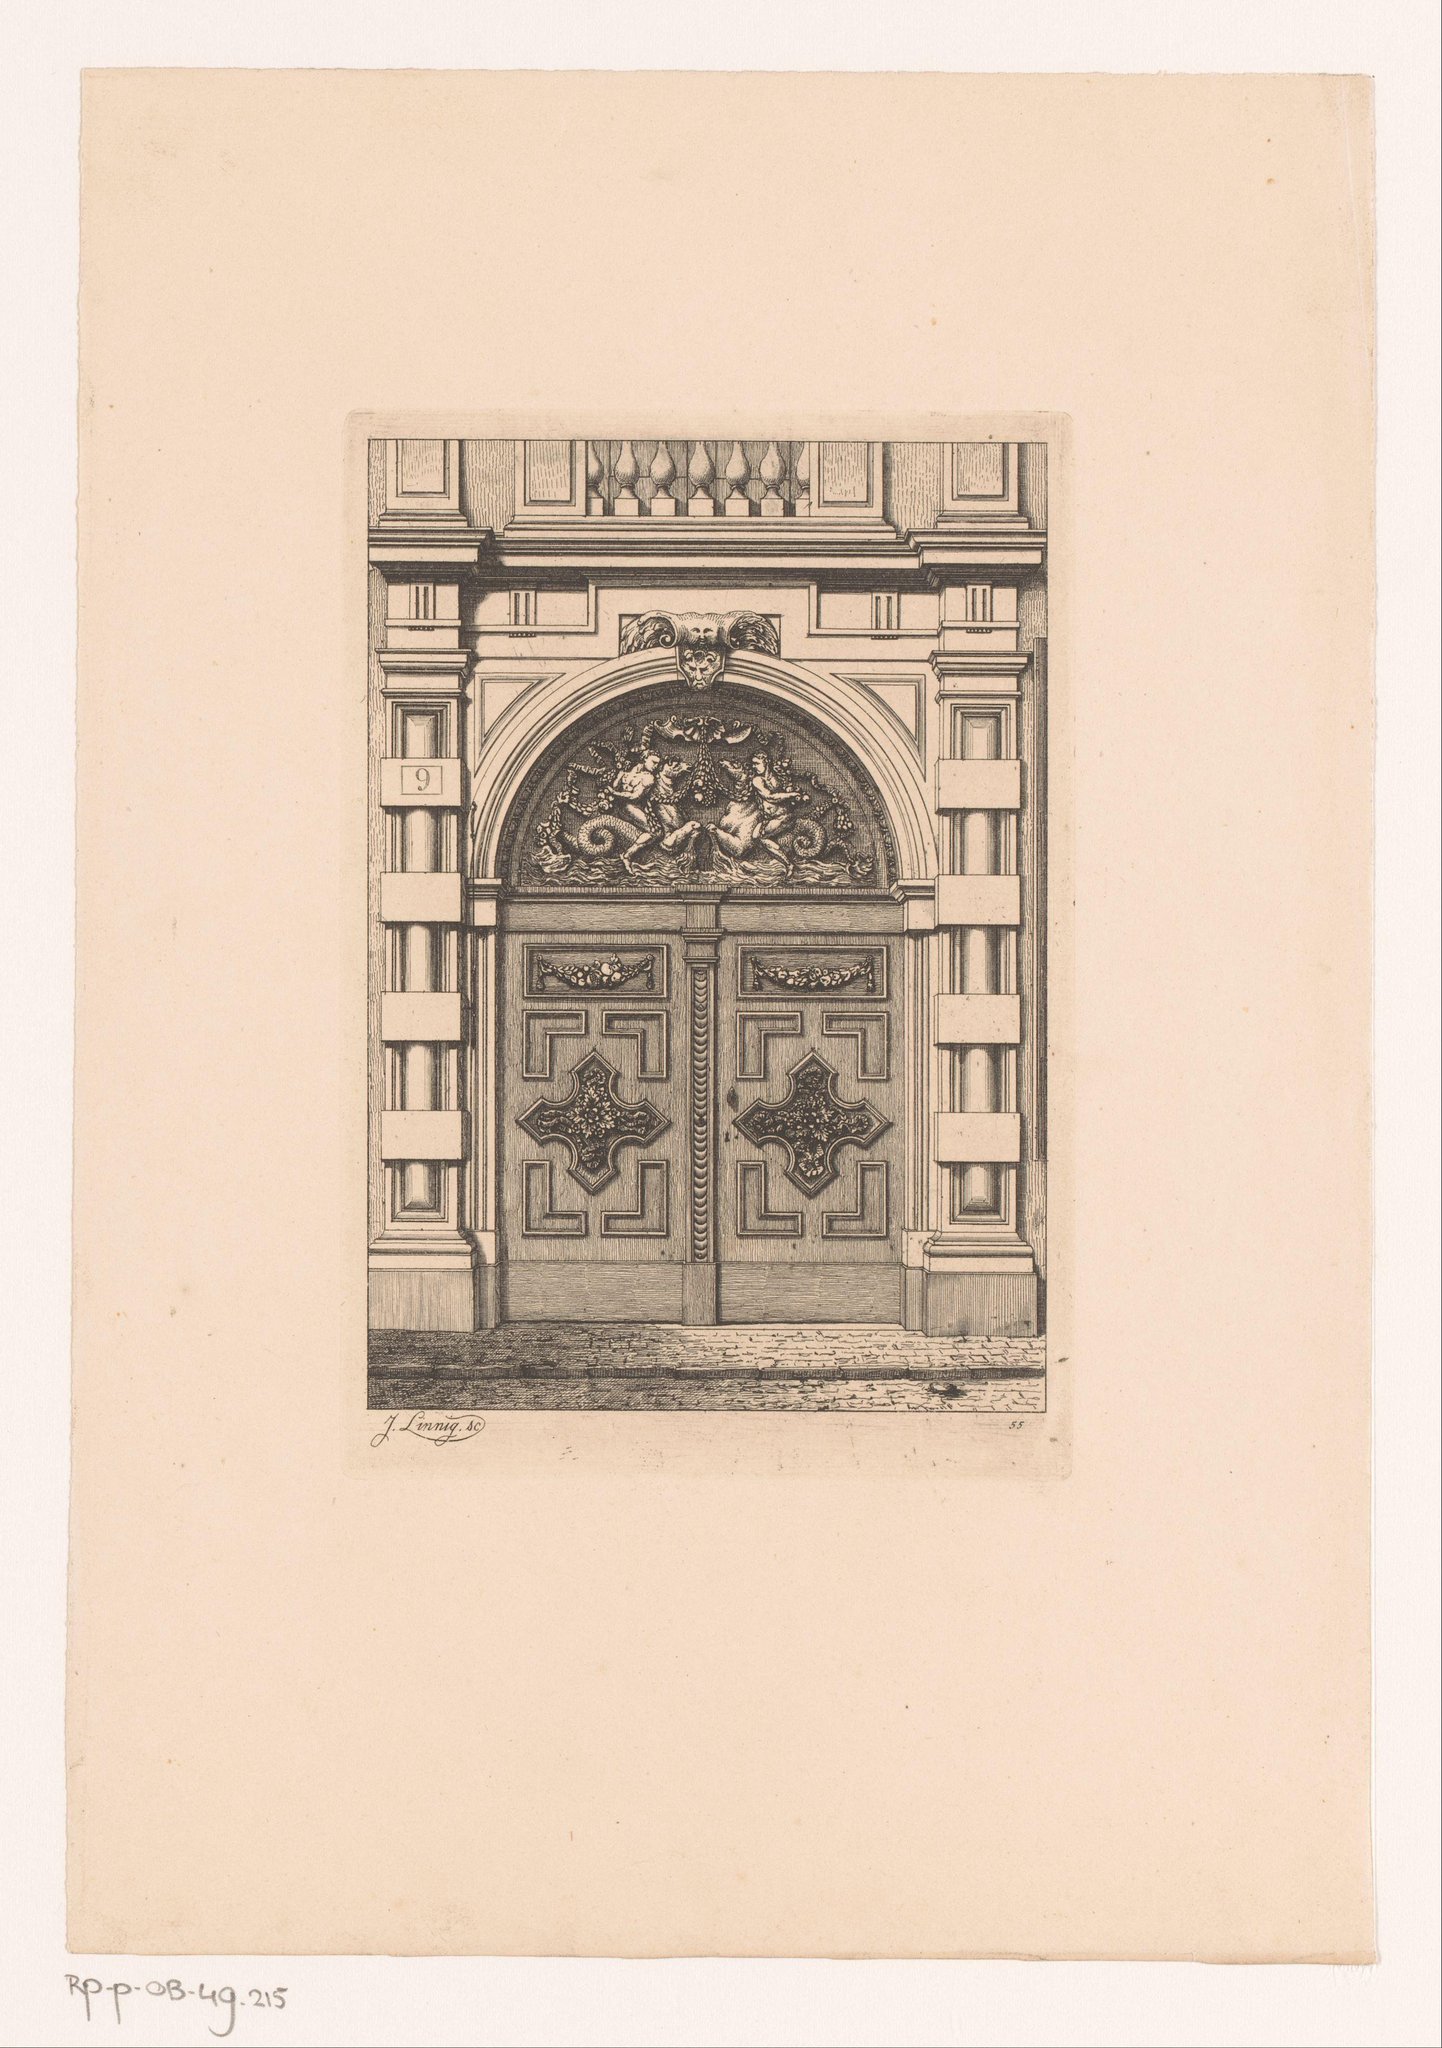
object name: print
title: Poort van een voormalig huis in de Keizerstraat in Antwerpen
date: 1868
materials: paper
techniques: etching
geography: antwerp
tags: gate, entrance, closed door, antwerp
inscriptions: collector's mark: Lugt 2228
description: Prent uit: Mertens, F.H. Album historique de la ville d'Anvers [...]. Antwerpen: J.E. Buschmann, 1868.